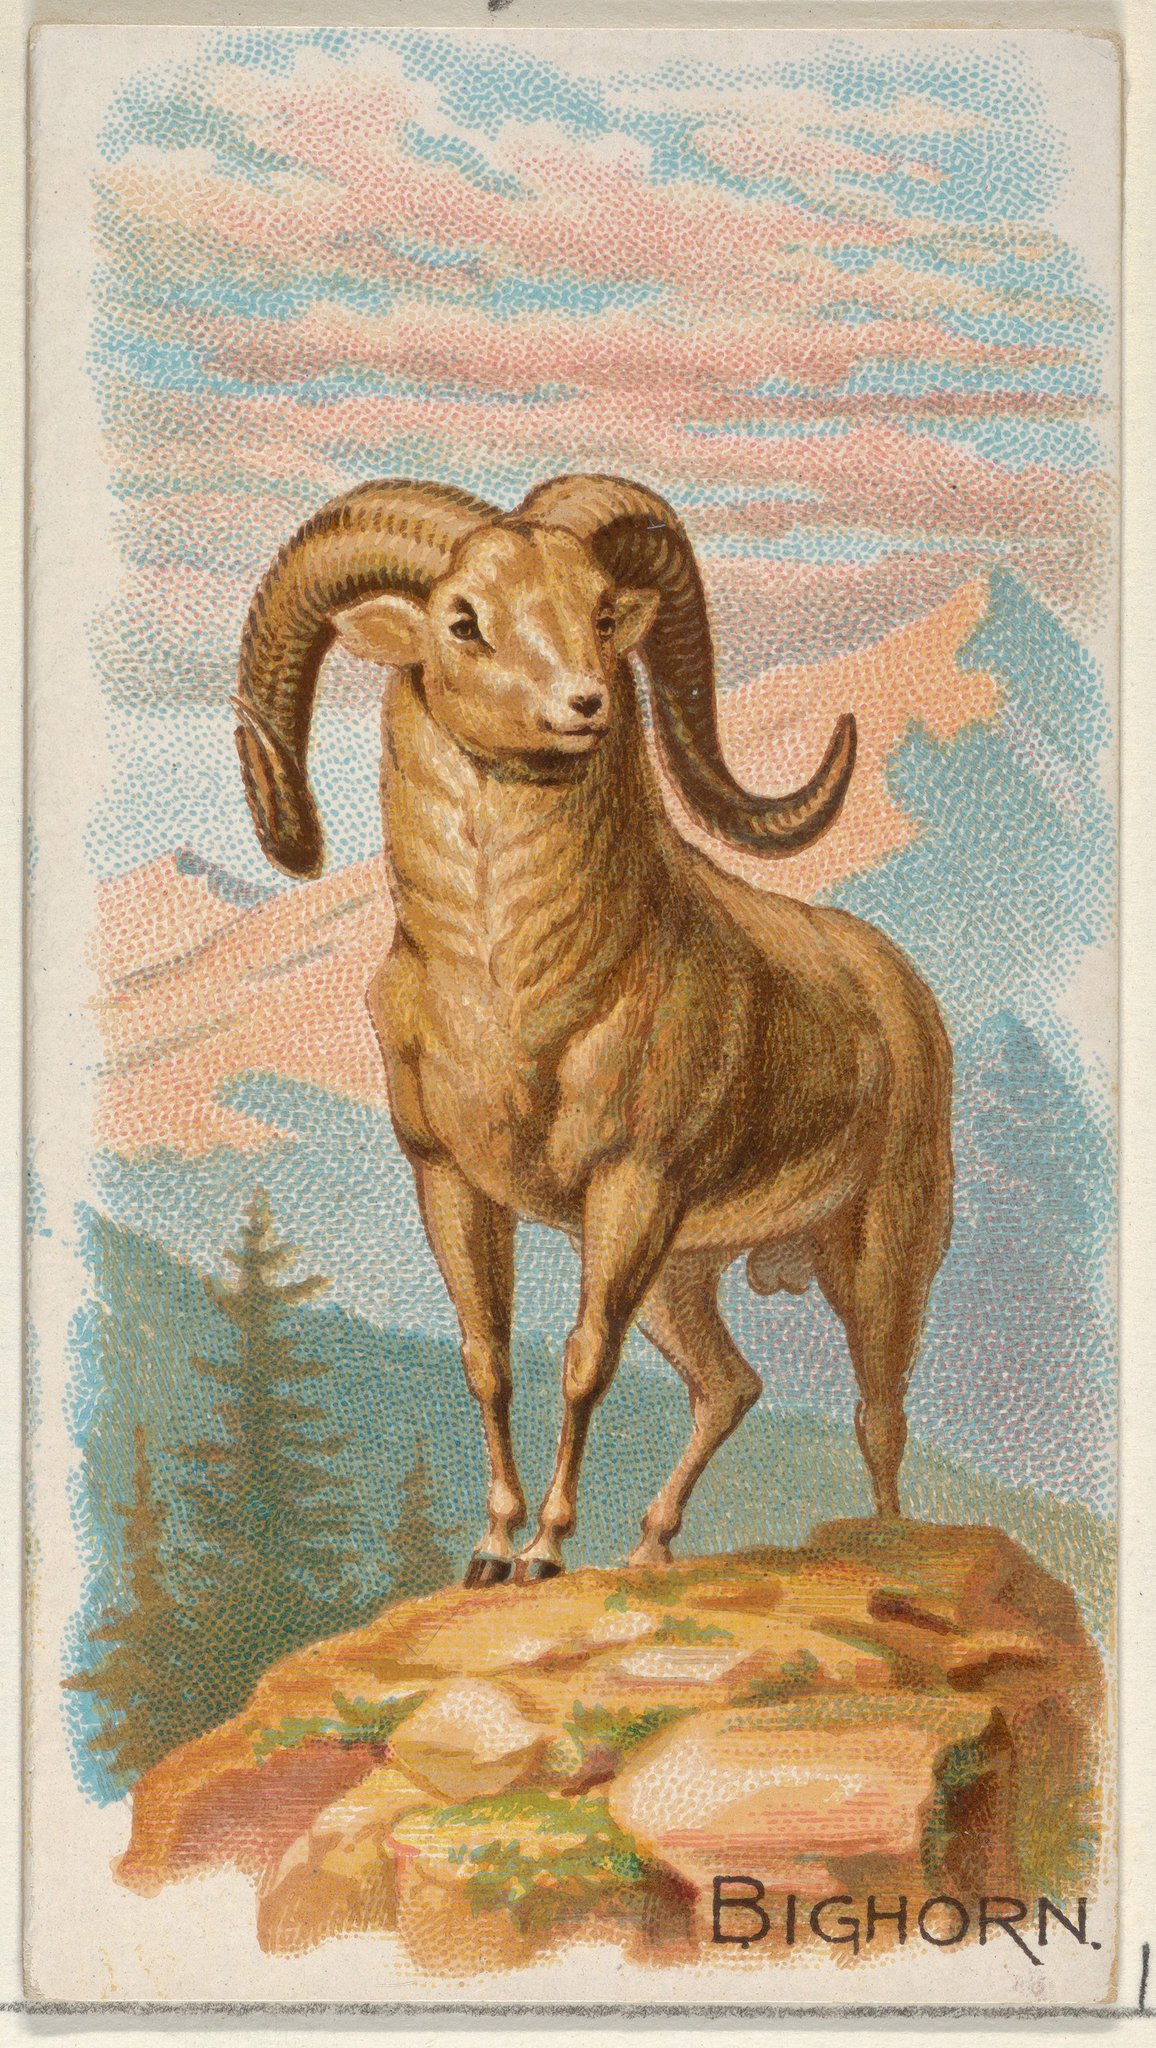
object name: print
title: Bighorn, from the Quadrupeds series (N21) for Allen & Ginter Cigarettes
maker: allen & ginter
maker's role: publisher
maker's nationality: american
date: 1890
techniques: color lithograph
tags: sheep